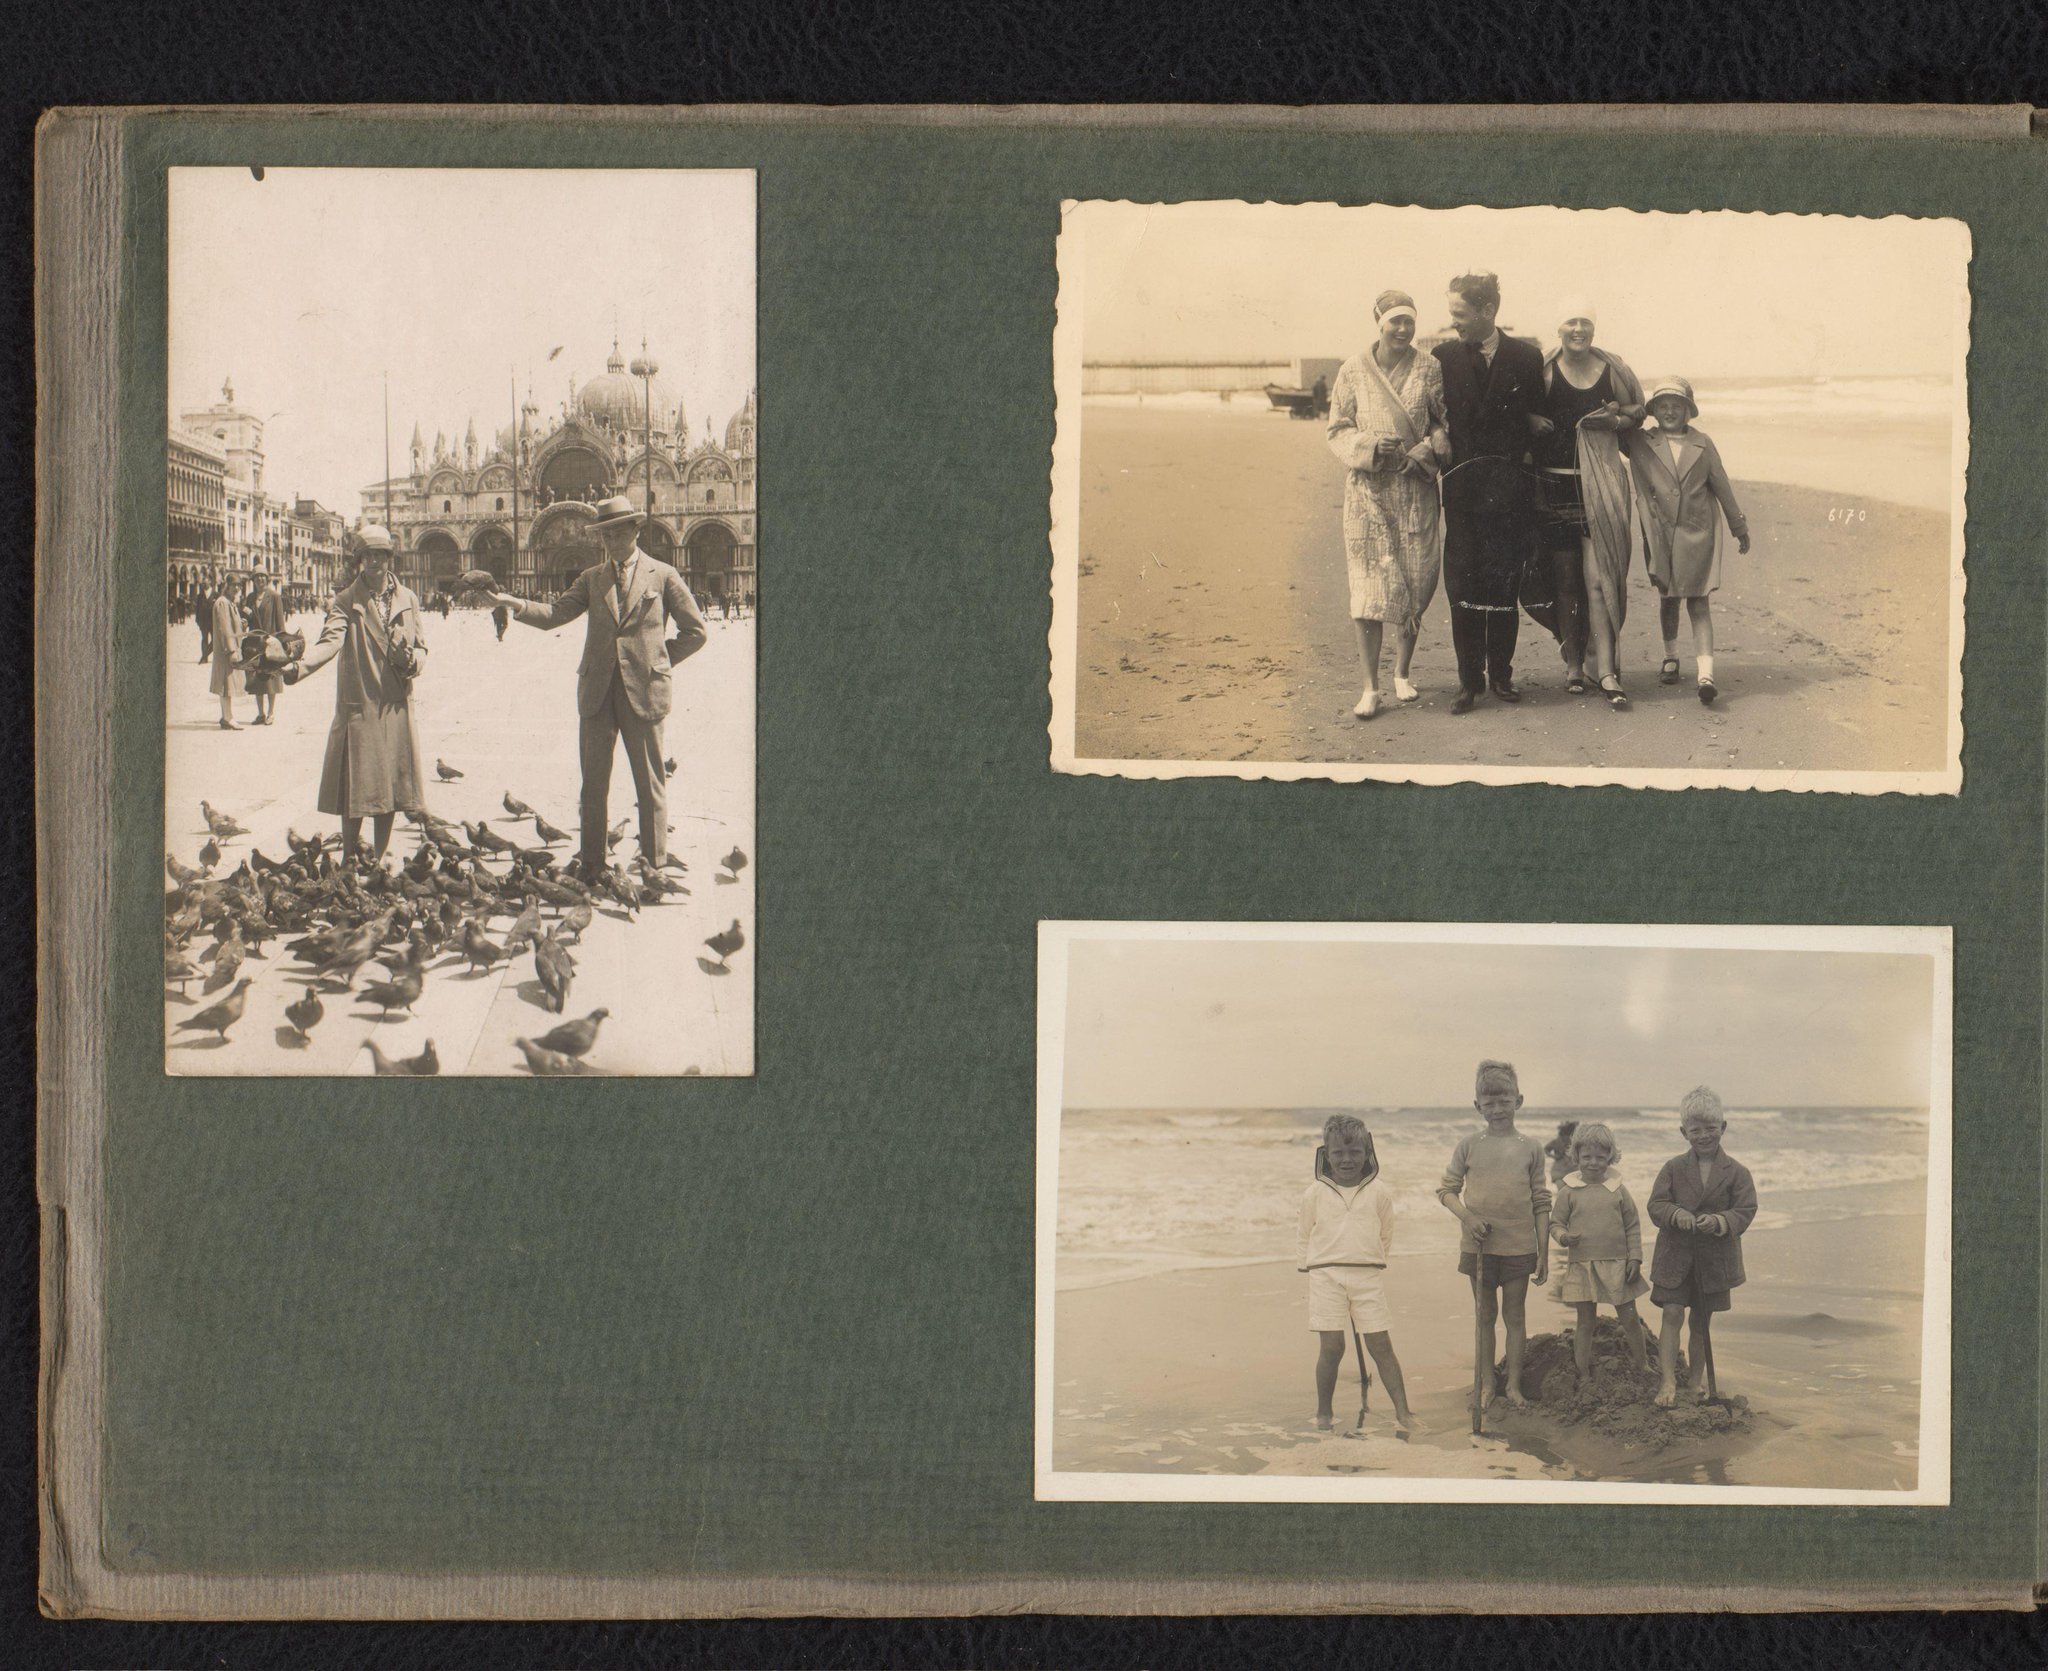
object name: photograph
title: Drie foto's van leden van familie Onnen-Van den Berg op een strand en op het San Marcoplein in Venetië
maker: jan jacobus kok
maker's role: fotograaf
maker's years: 1880-1955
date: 1905-1920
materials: paper, cardboard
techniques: gelatin silver print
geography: hilversum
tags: beach (as place of recreation), square, place, circus, etc., historical persons - bb - woman, strolling, historical persons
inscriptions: number: ‘6170’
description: Deze foto's maken deel uit van een album.